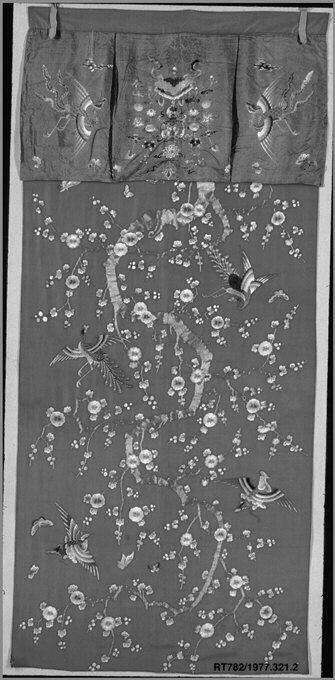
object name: wedding festival hanging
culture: chinese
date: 1701-1800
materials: gold, silk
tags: mythical creatures,flowers